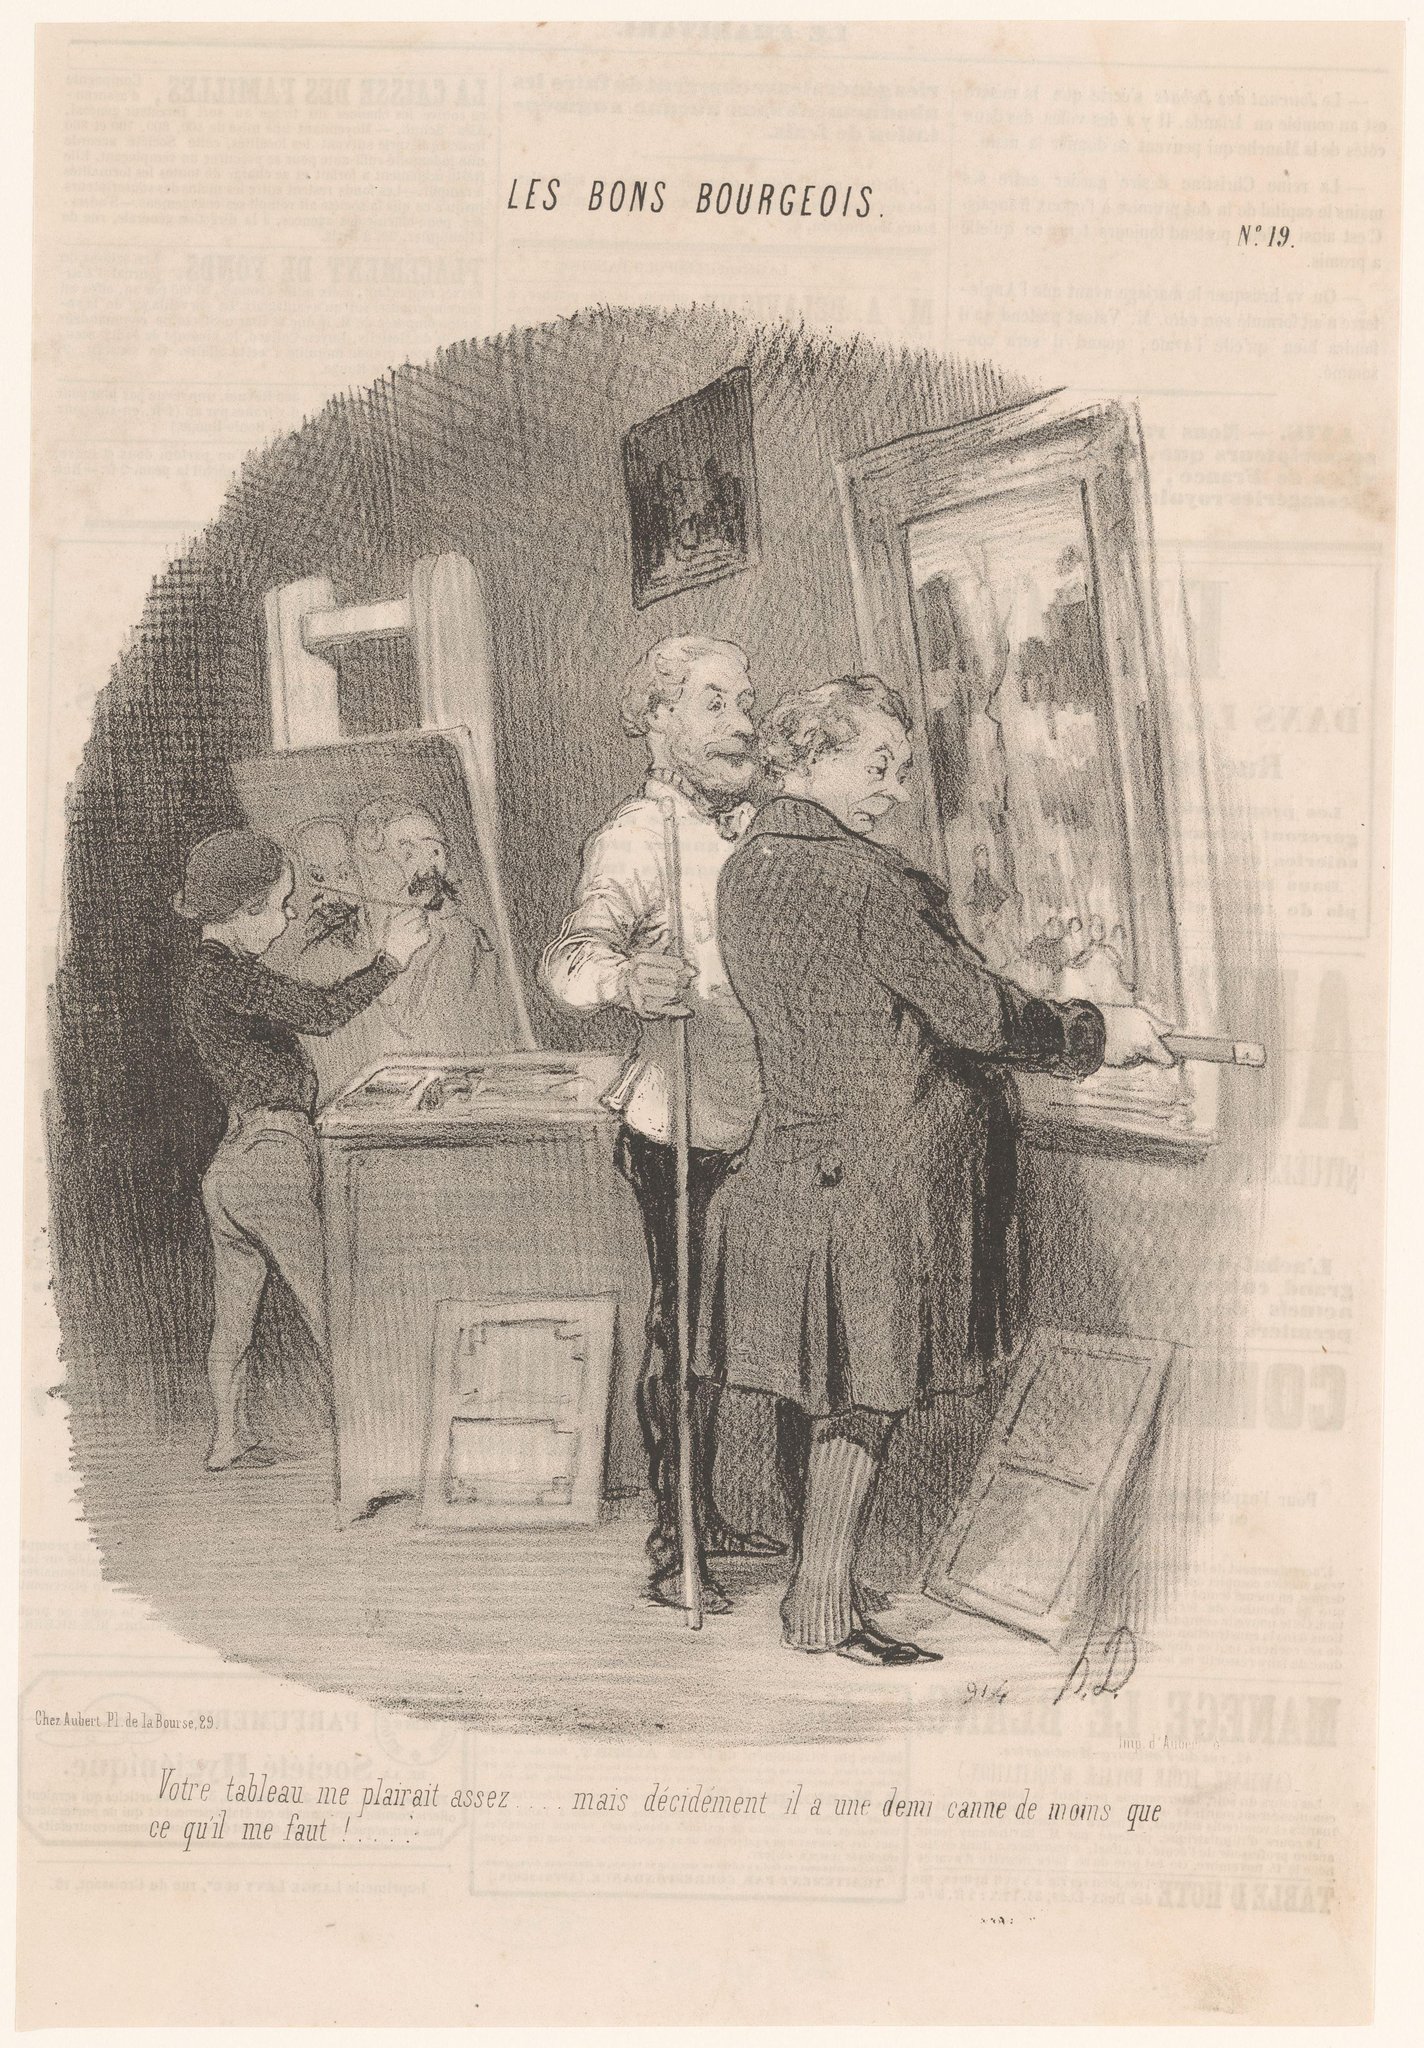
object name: cartoon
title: Les bons bourgeois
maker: honoré daumier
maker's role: draughtsman, painter, print maker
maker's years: 1808-1879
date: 1846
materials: paper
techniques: lithograph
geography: paris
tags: caricatures (human types), measuring, picture, painting, patron (or client) visiting the artist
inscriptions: collector's mark: Lugt 2228a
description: In de achtergrond bekladt een jongen een schilderij van de kunstenaar.